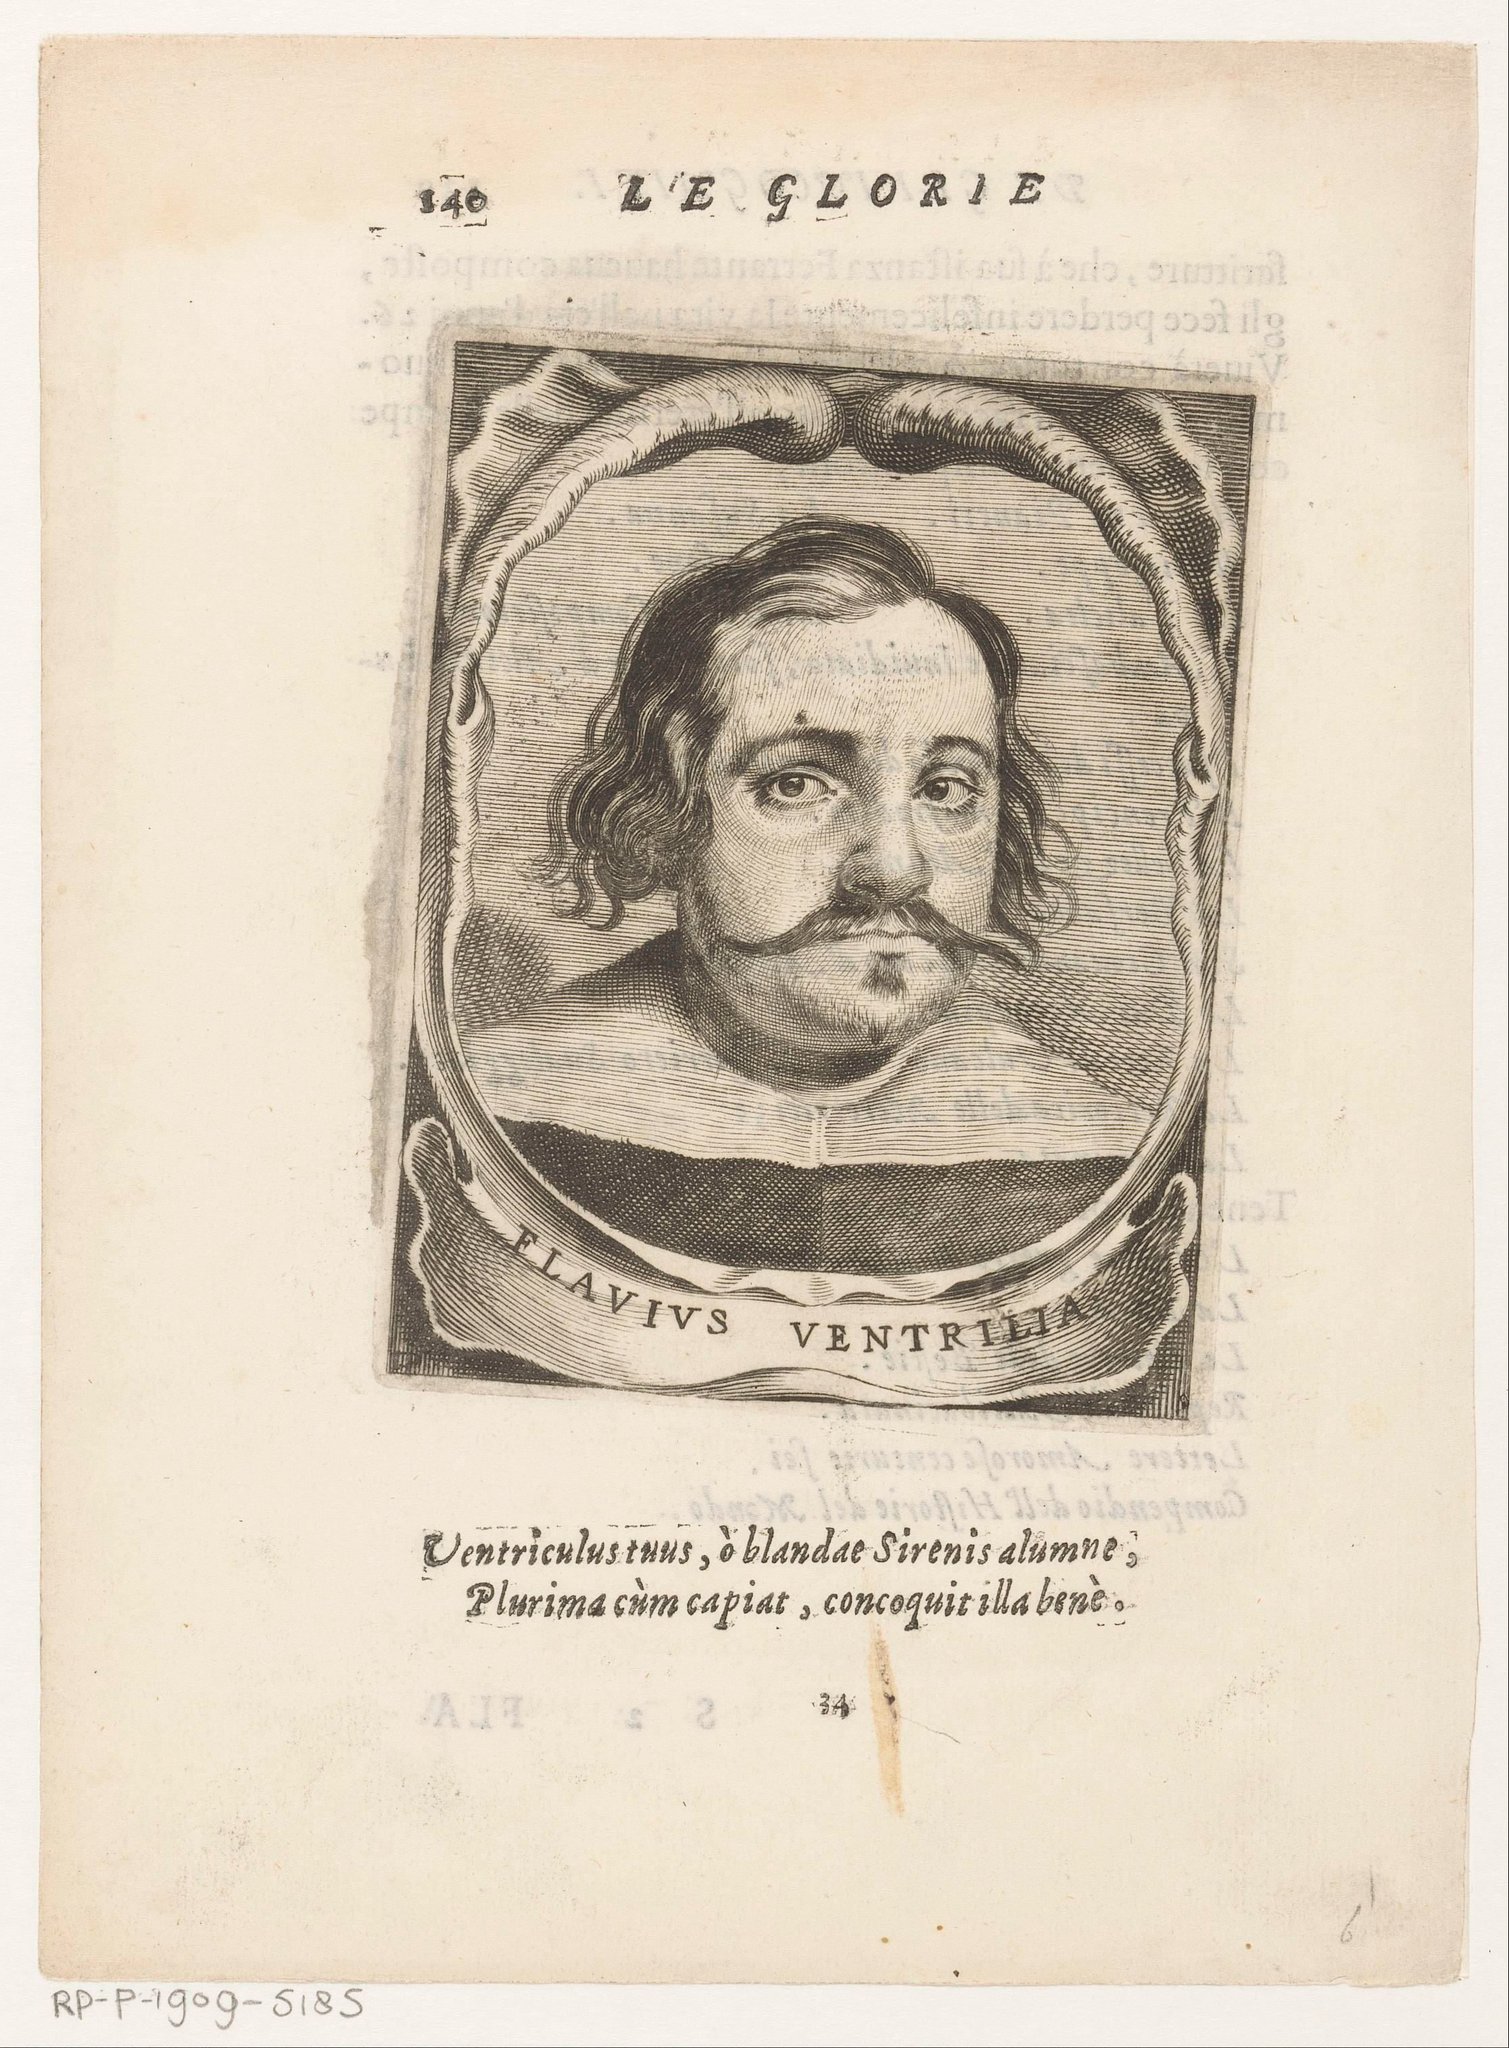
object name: book illustration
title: Portret van Flavio Ventriglia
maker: appresso francesco valuasense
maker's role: printer, publisher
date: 1647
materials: paper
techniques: engraving, letterpress printing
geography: venice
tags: historical persons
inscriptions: collector's mark: Lugt 2228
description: Prent uit de publicatie: Loredan, Giovan Francesco. Le glorie degli Incogniti. Venetië: Francesco Valvasense, 1647, p. 140.